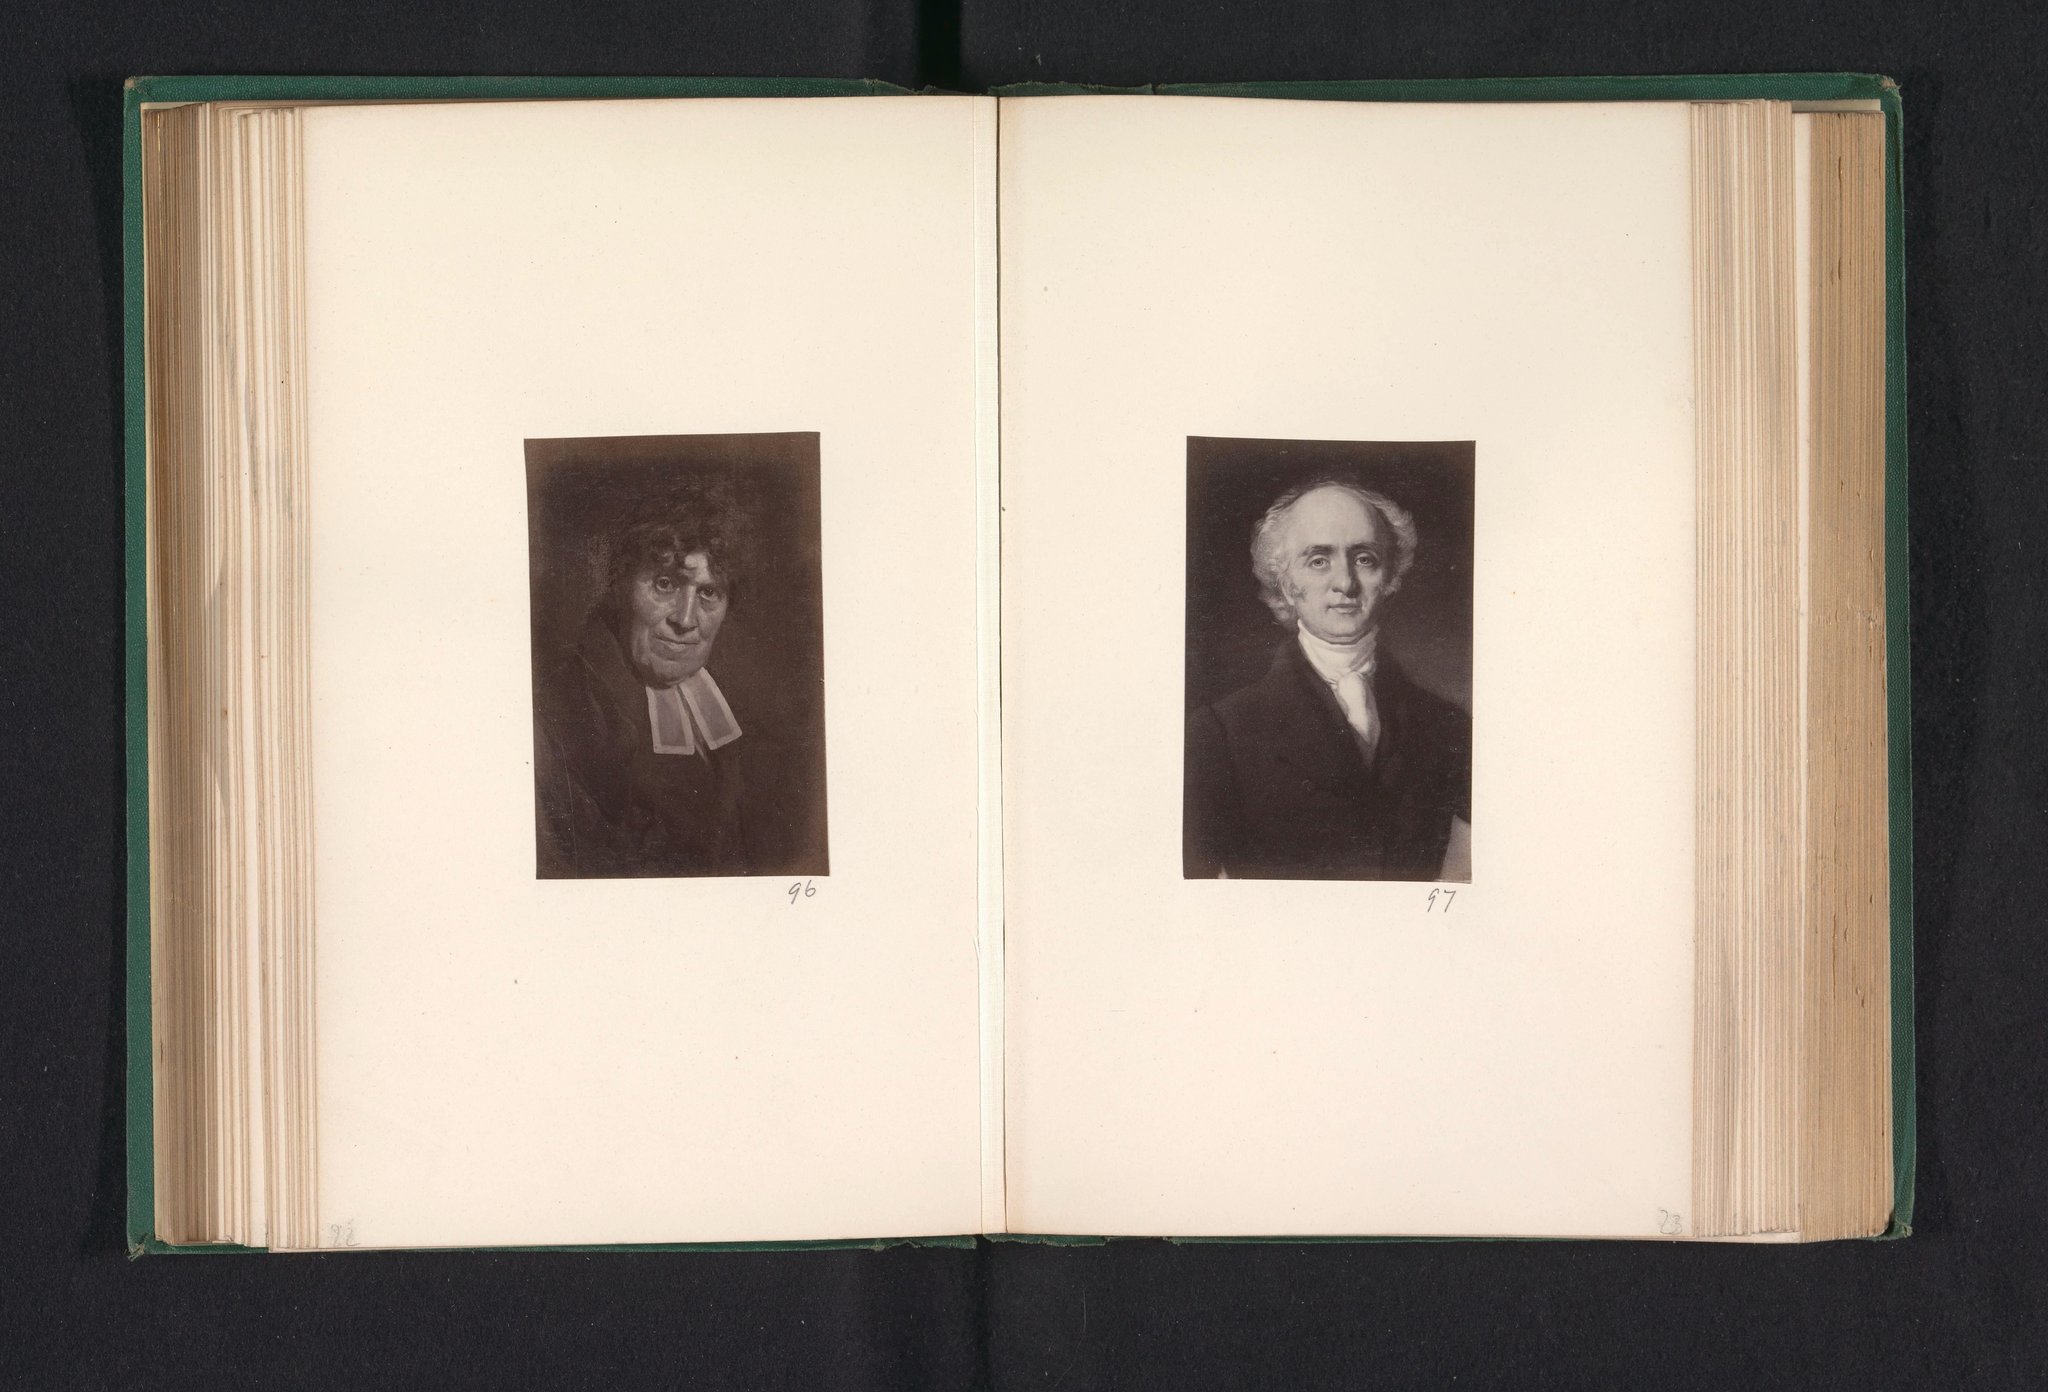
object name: page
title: Fotoreproductie van een schilderij, voorstellende een portret van John Burns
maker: thomas annan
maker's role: fotograaf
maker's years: 1829-1887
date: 1863-1868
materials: photographic support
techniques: albumen print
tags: historical persons (portraits and scenes from the life) (+ (full) bust portrait)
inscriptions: number: ‘96’